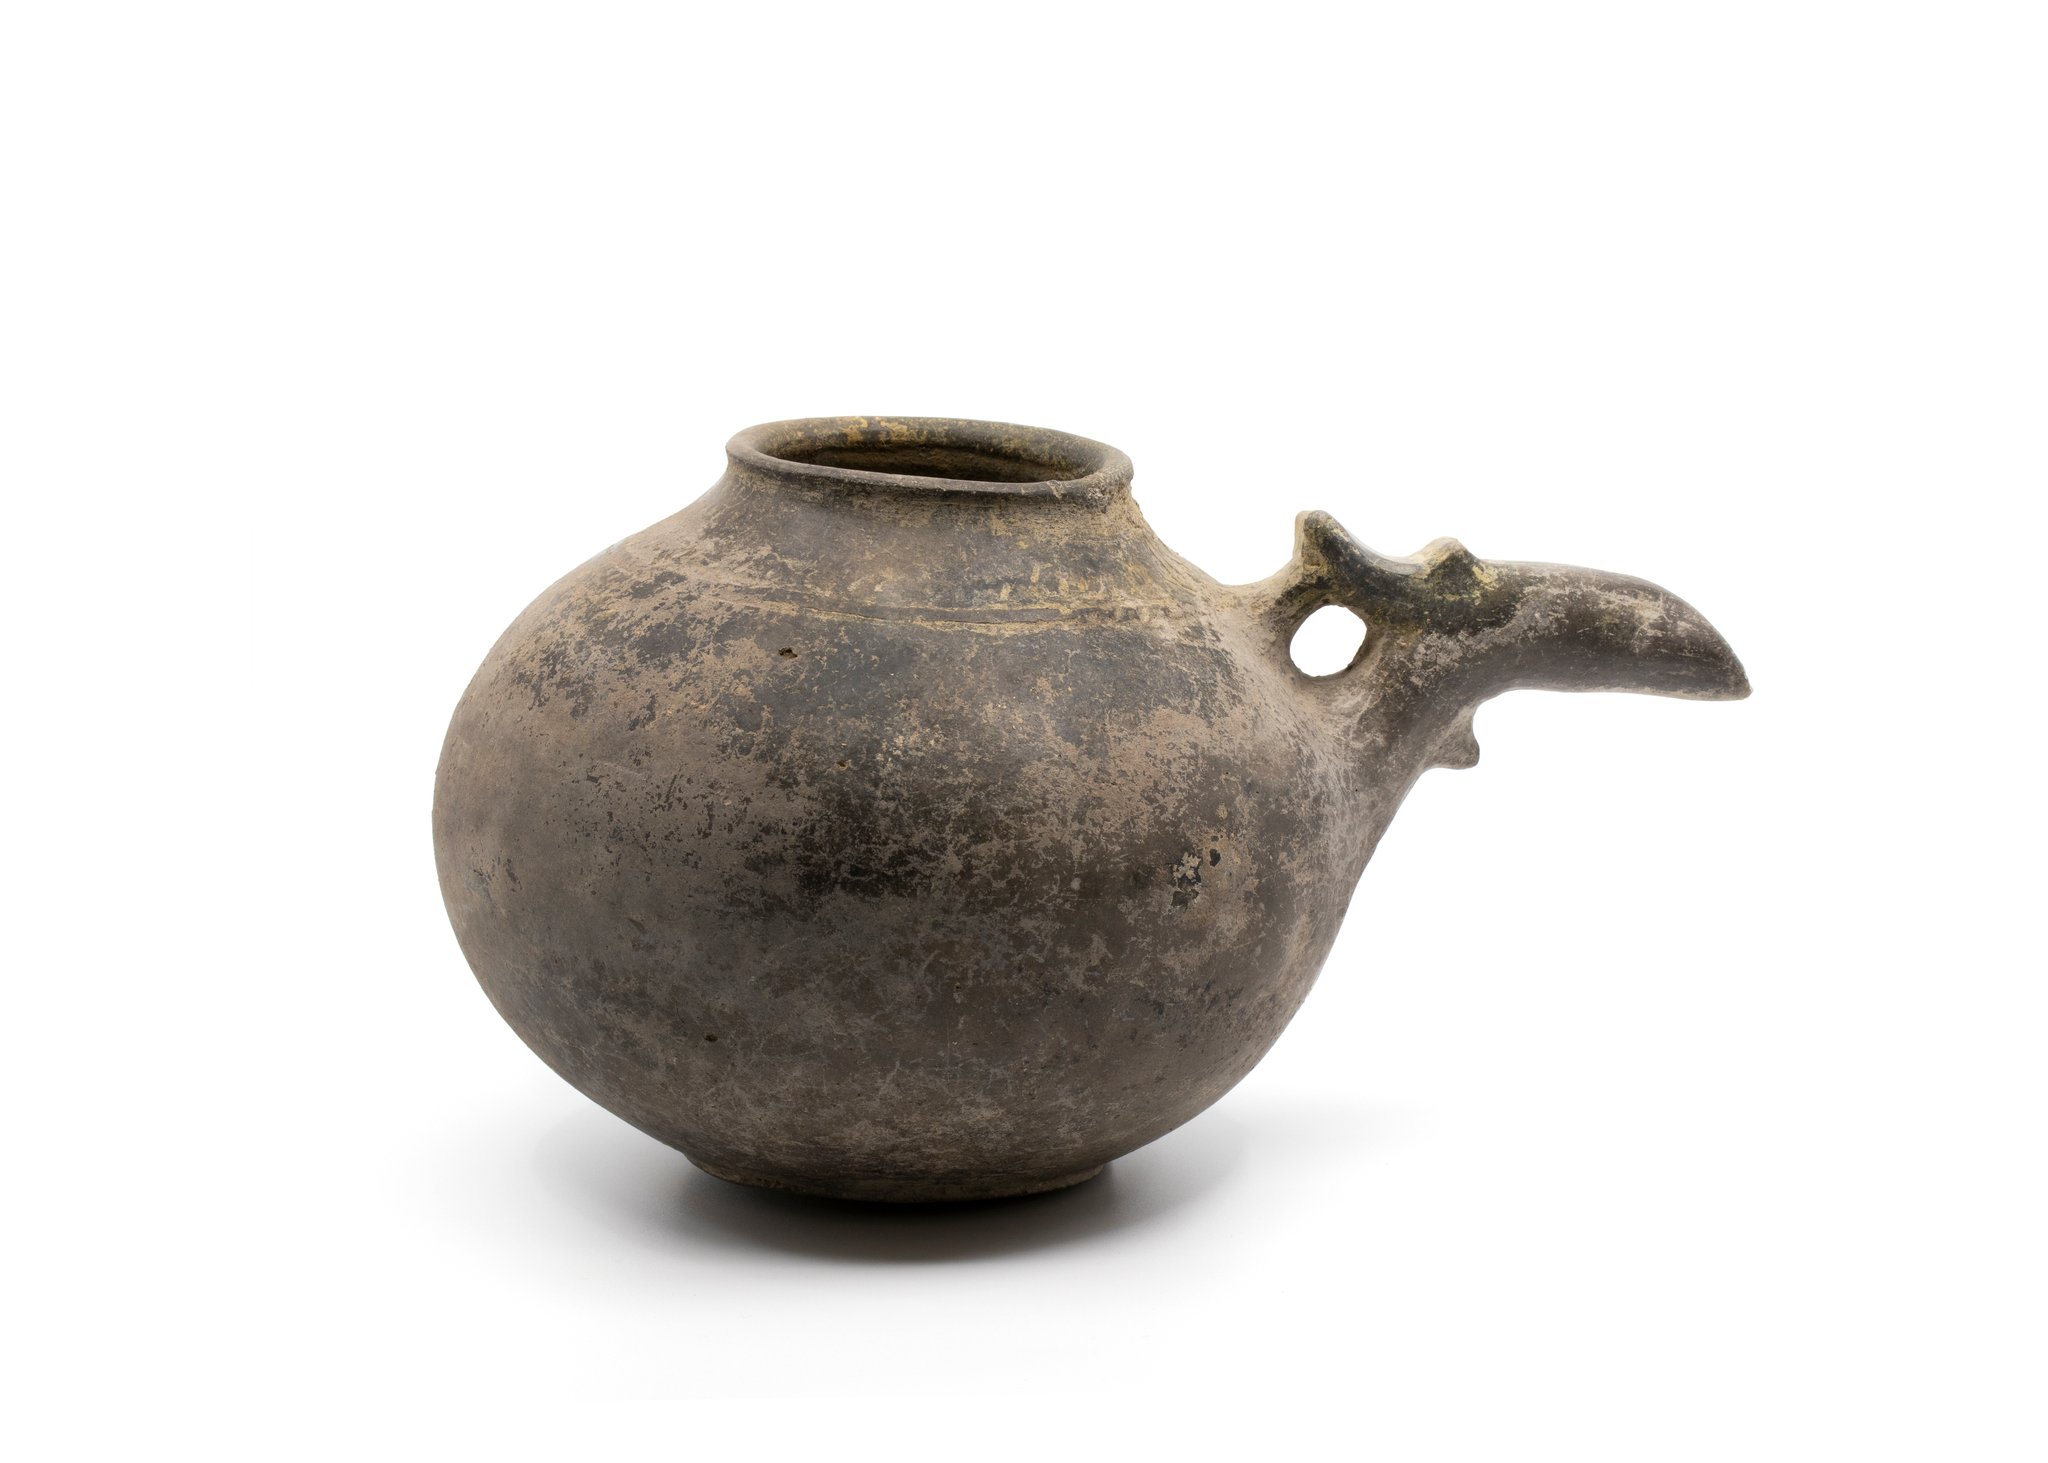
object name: pitcher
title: Spouted pitcher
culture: iranian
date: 1050-800 BCE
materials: ceramic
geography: iran